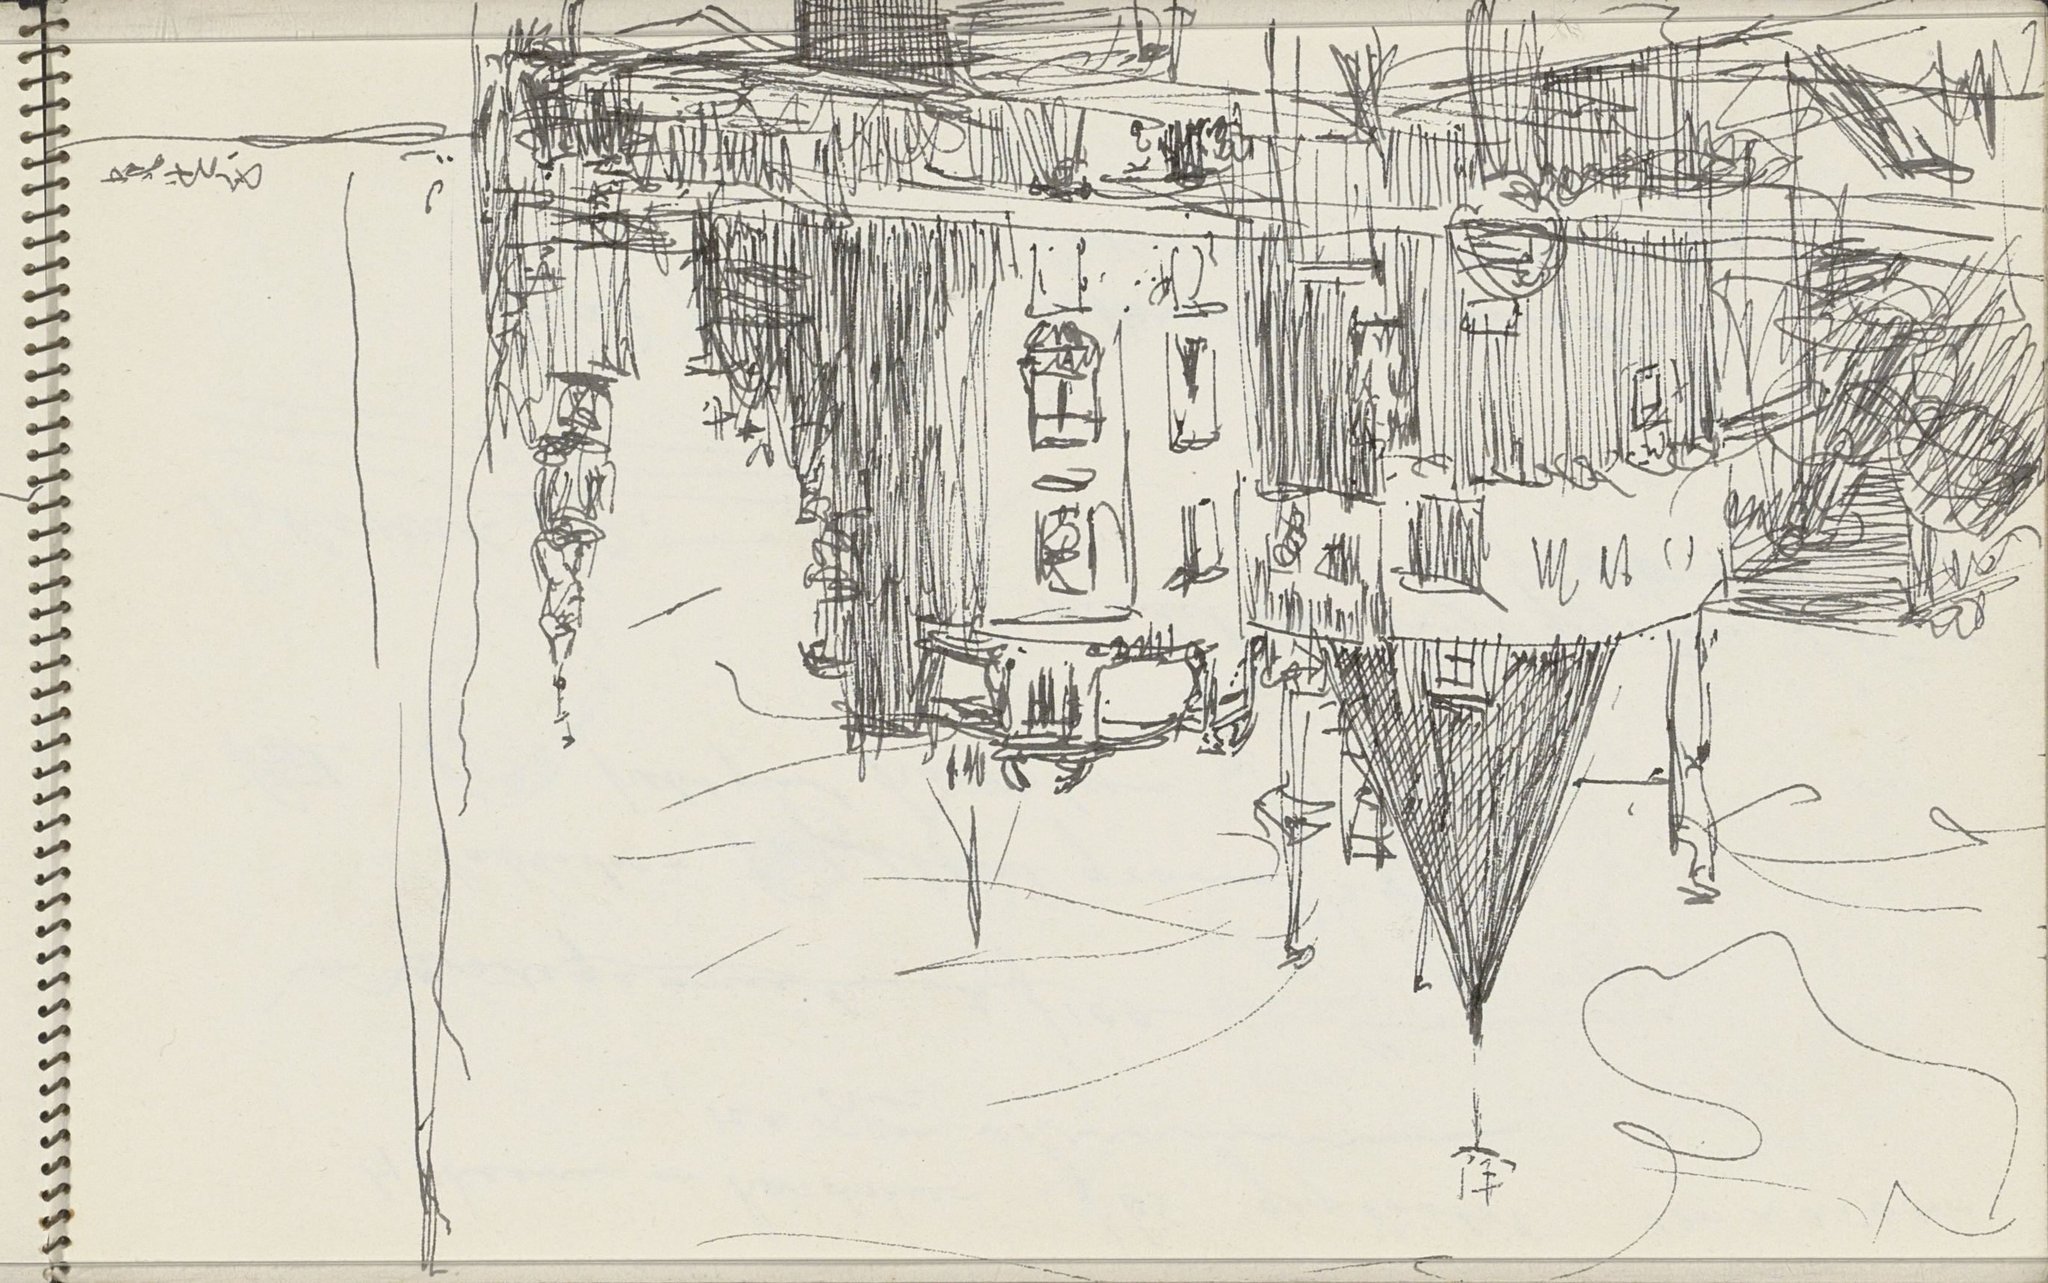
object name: sketchbook leaf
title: Schreierstoren te Amsterdam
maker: carel adolph lion cachet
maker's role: draughtsman, print maker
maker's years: 1864-1945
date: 1930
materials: ink, paper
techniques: pen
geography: amsterdam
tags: towers ~ fortified city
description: Blad 9 recto uit een schetsboek met 20 bladen.